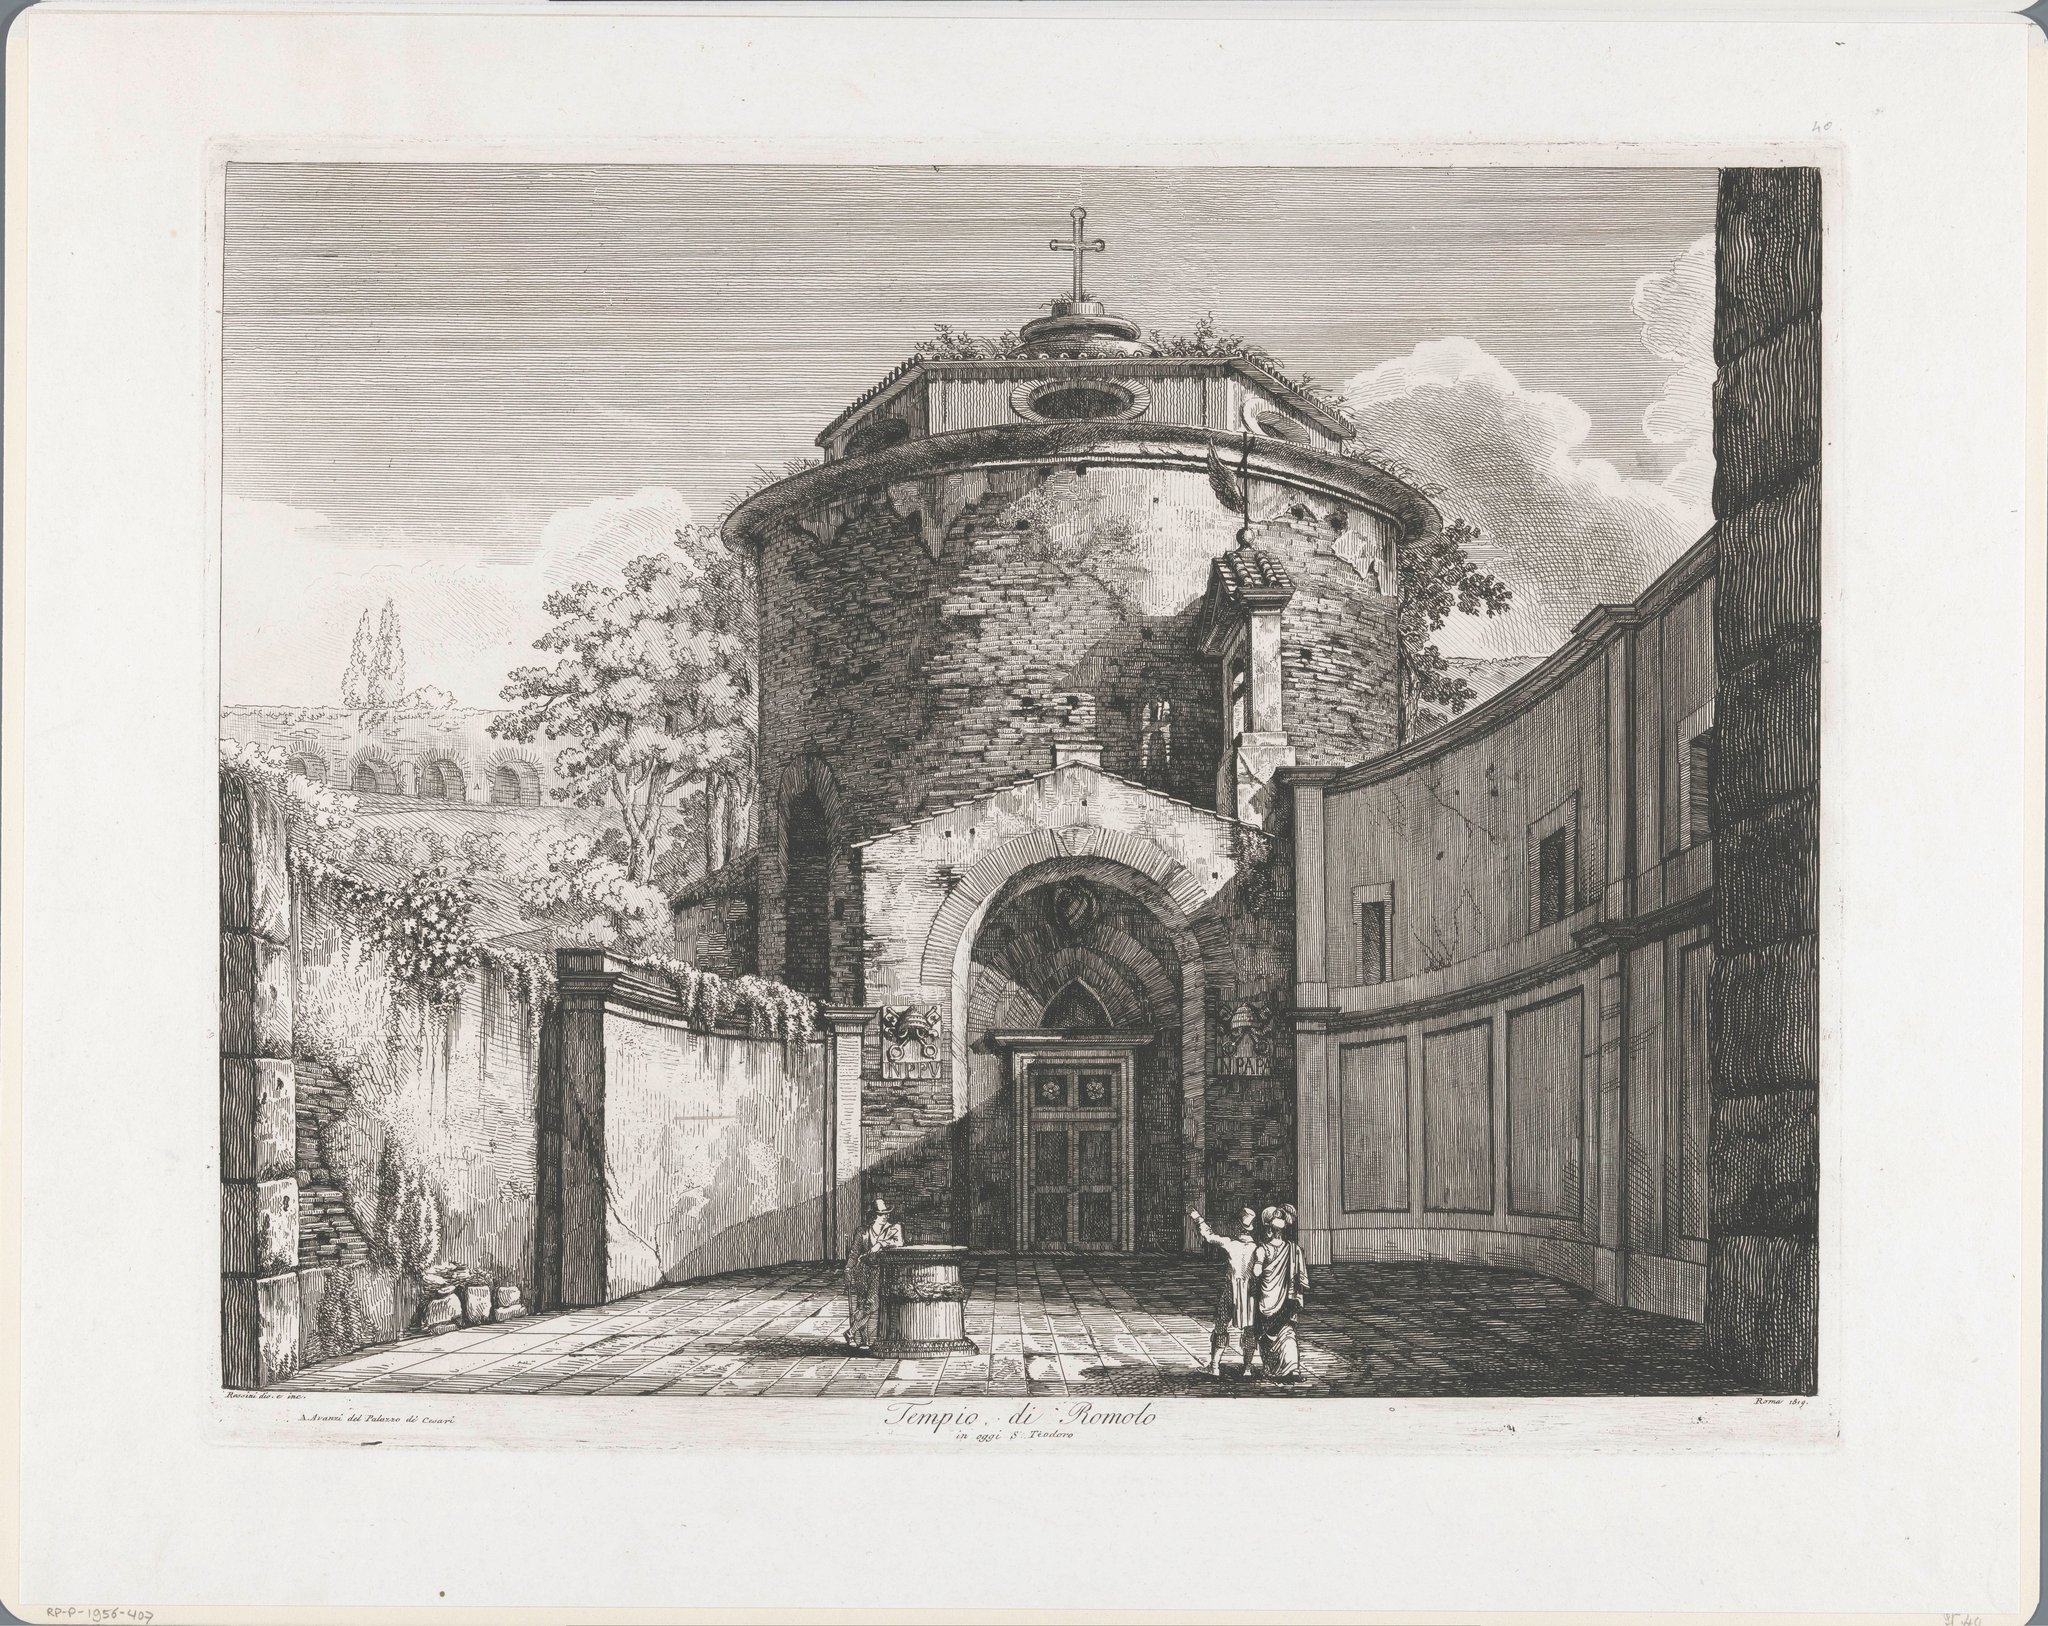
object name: print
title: Tempio de Romolo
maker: luigi rossini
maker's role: print maker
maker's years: 1790-1857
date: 1819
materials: paper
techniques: etching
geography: rome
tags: ruin of a building ~ architecture, temple, shrine ~ roman religion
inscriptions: collector's mark: Lugt 2228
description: Gezicht op de ronde bakstenen Tempel van Romulus aan de Via Sacra op het Forum Romanum te Rome. Titel in het Italiaans in ondermarge.